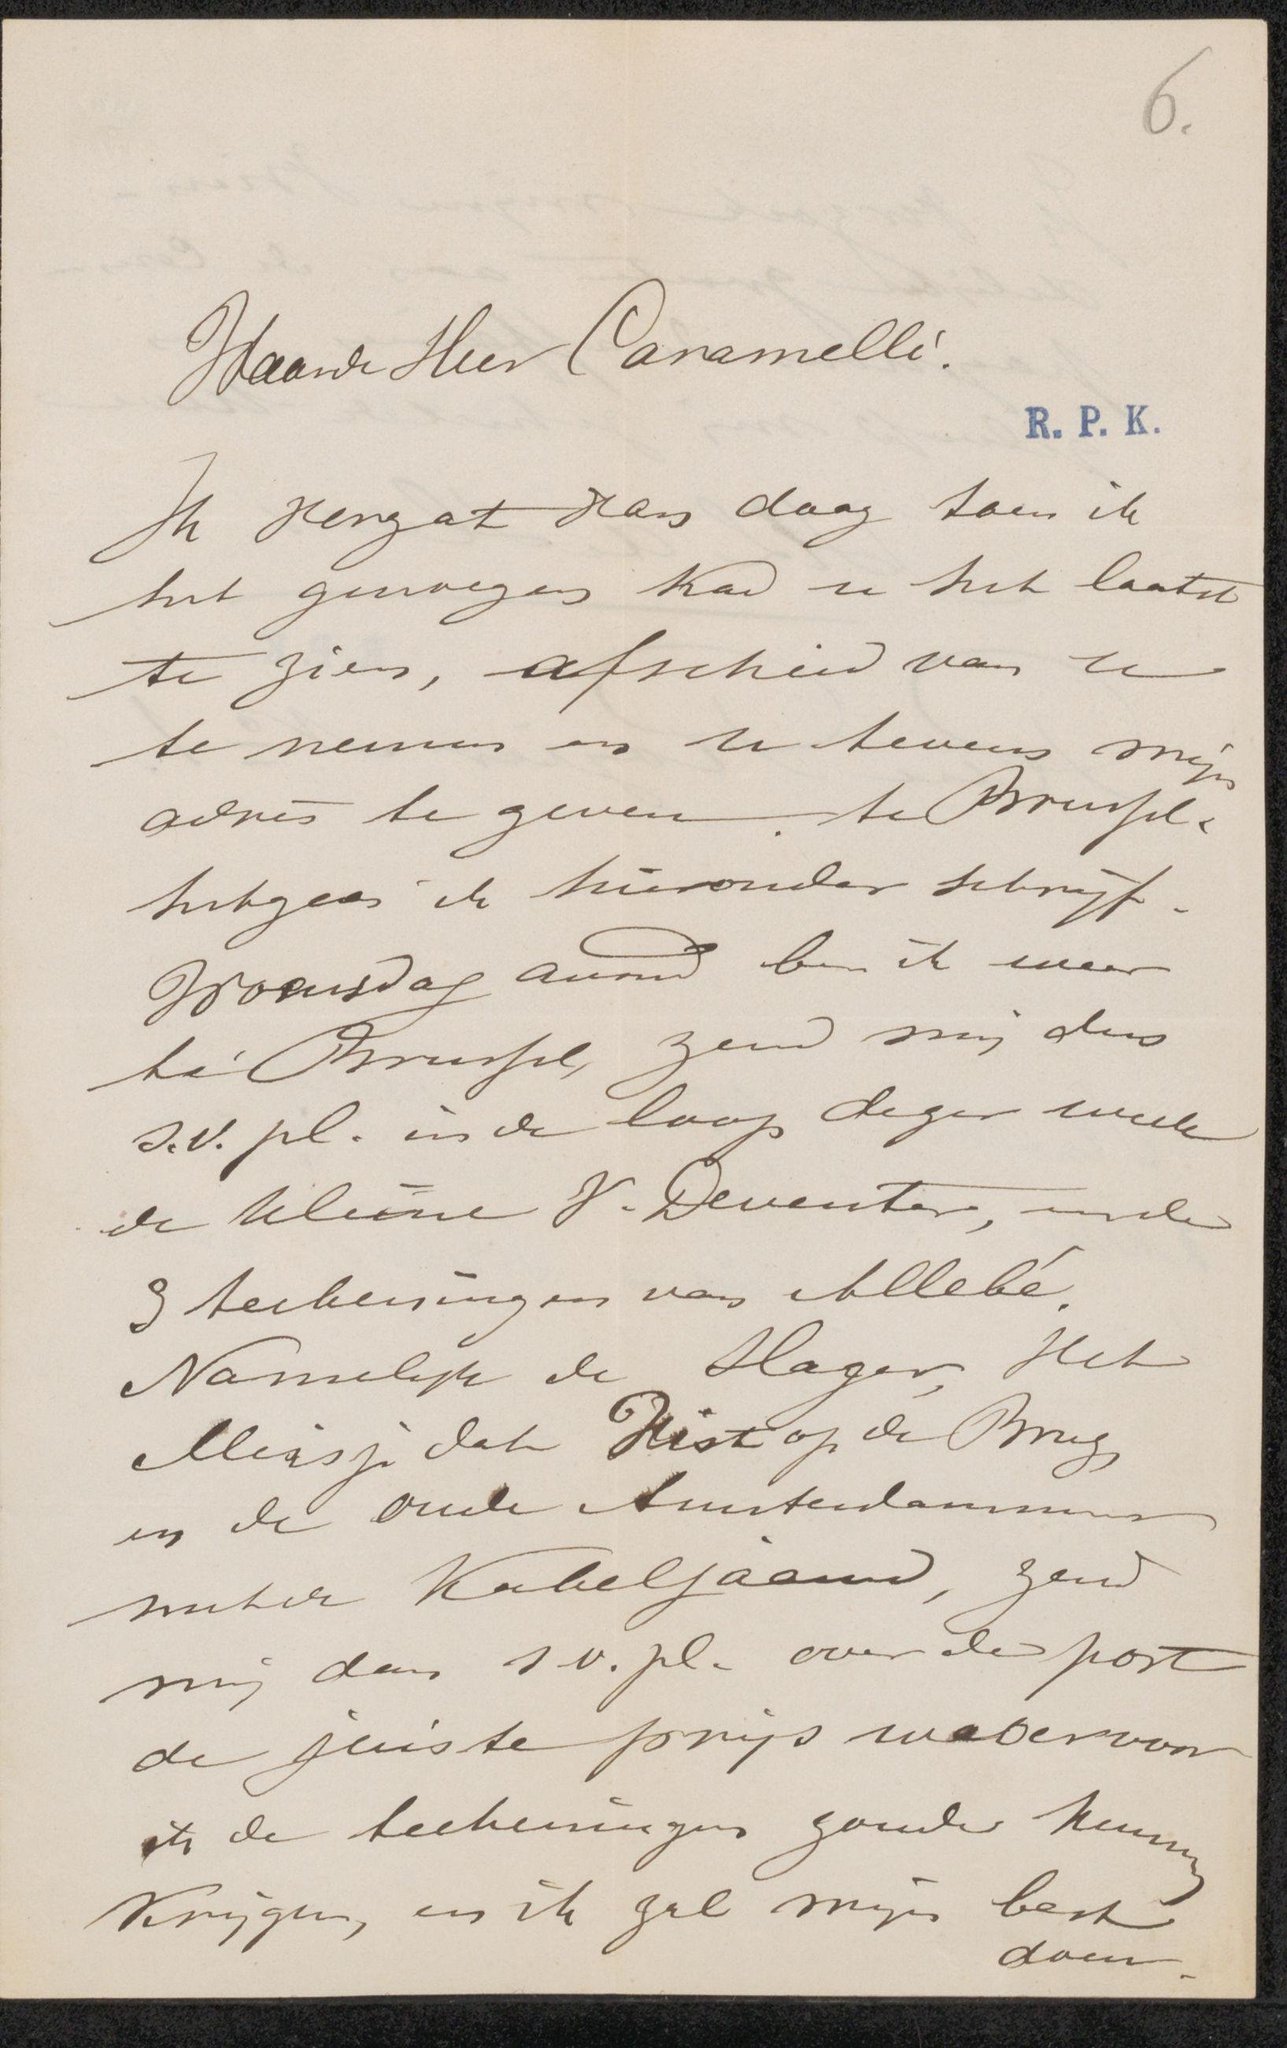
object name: letter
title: Brief aan Alberto Caramelli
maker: johannes hubertus leonardus de haas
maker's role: draughtsman, painter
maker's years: 1832-1908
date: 1842-1891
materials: ink, paper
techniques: pen, writing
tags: utrecht, alberto caramelli, august allebé, the hague, print maker, willem anthonie van deventer, art trade, art shop, drawing, brussels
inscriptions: collector's mark: Lugt 2233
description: Brief gedateerd april 64 in latere hand.